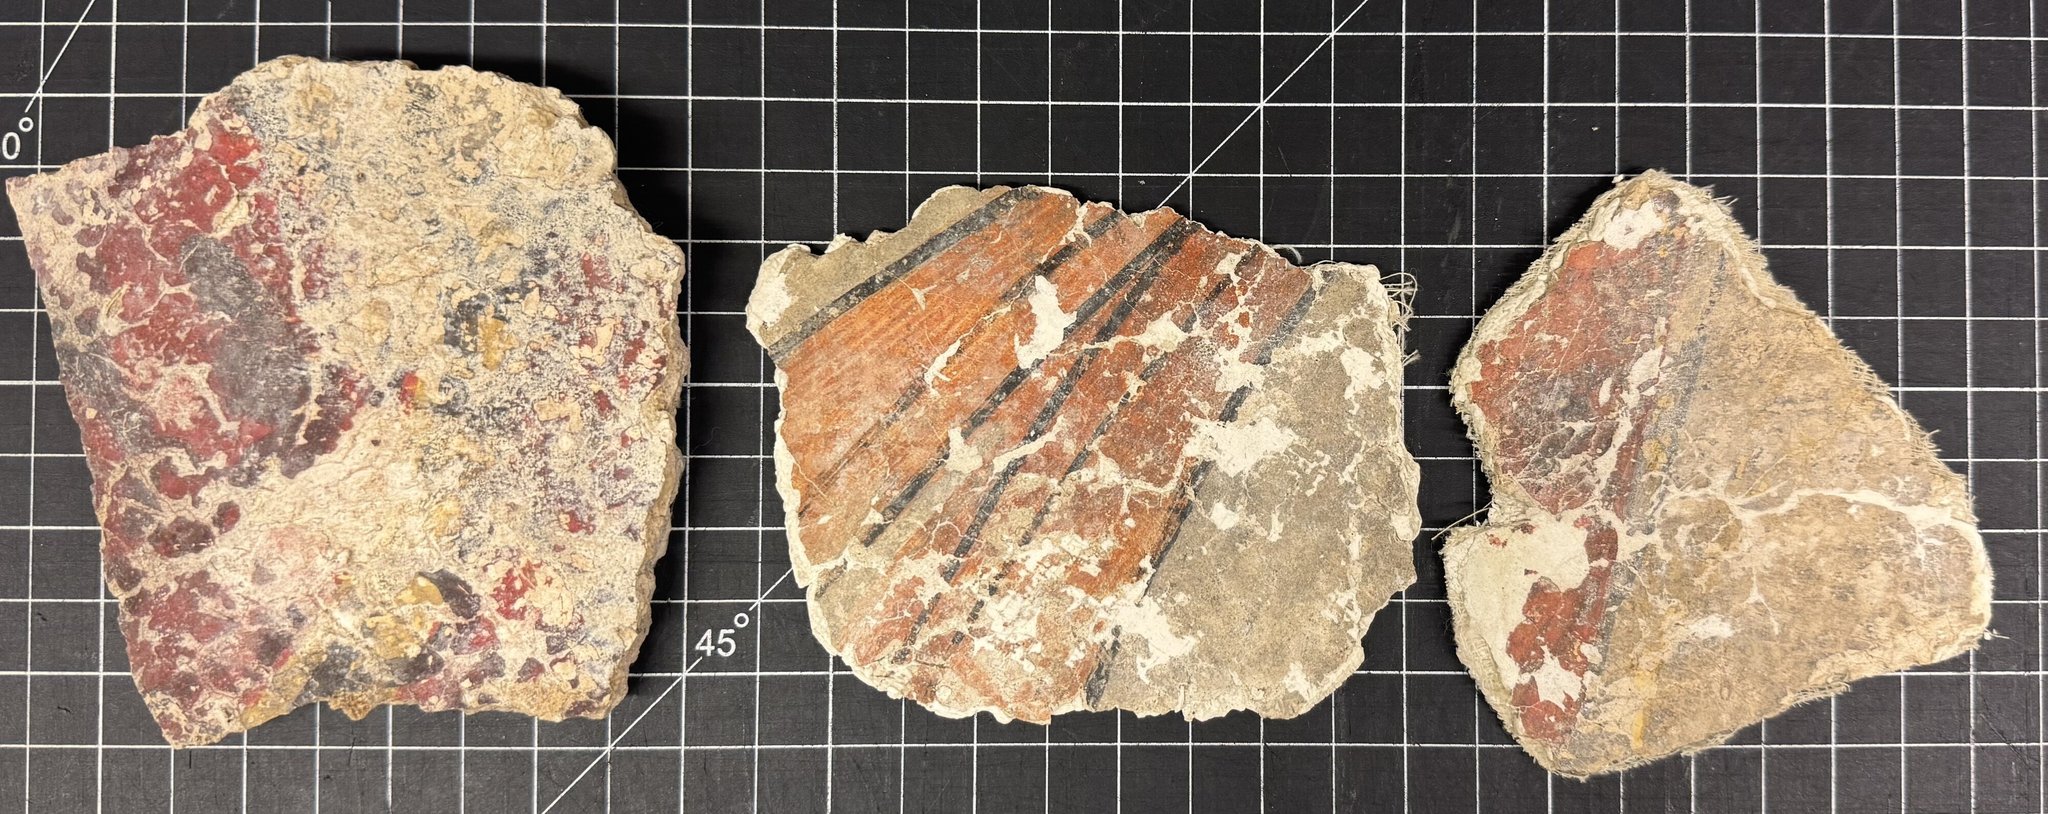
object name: fragment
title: Stucco Fragment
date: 1101-1200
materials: plaster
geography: iran